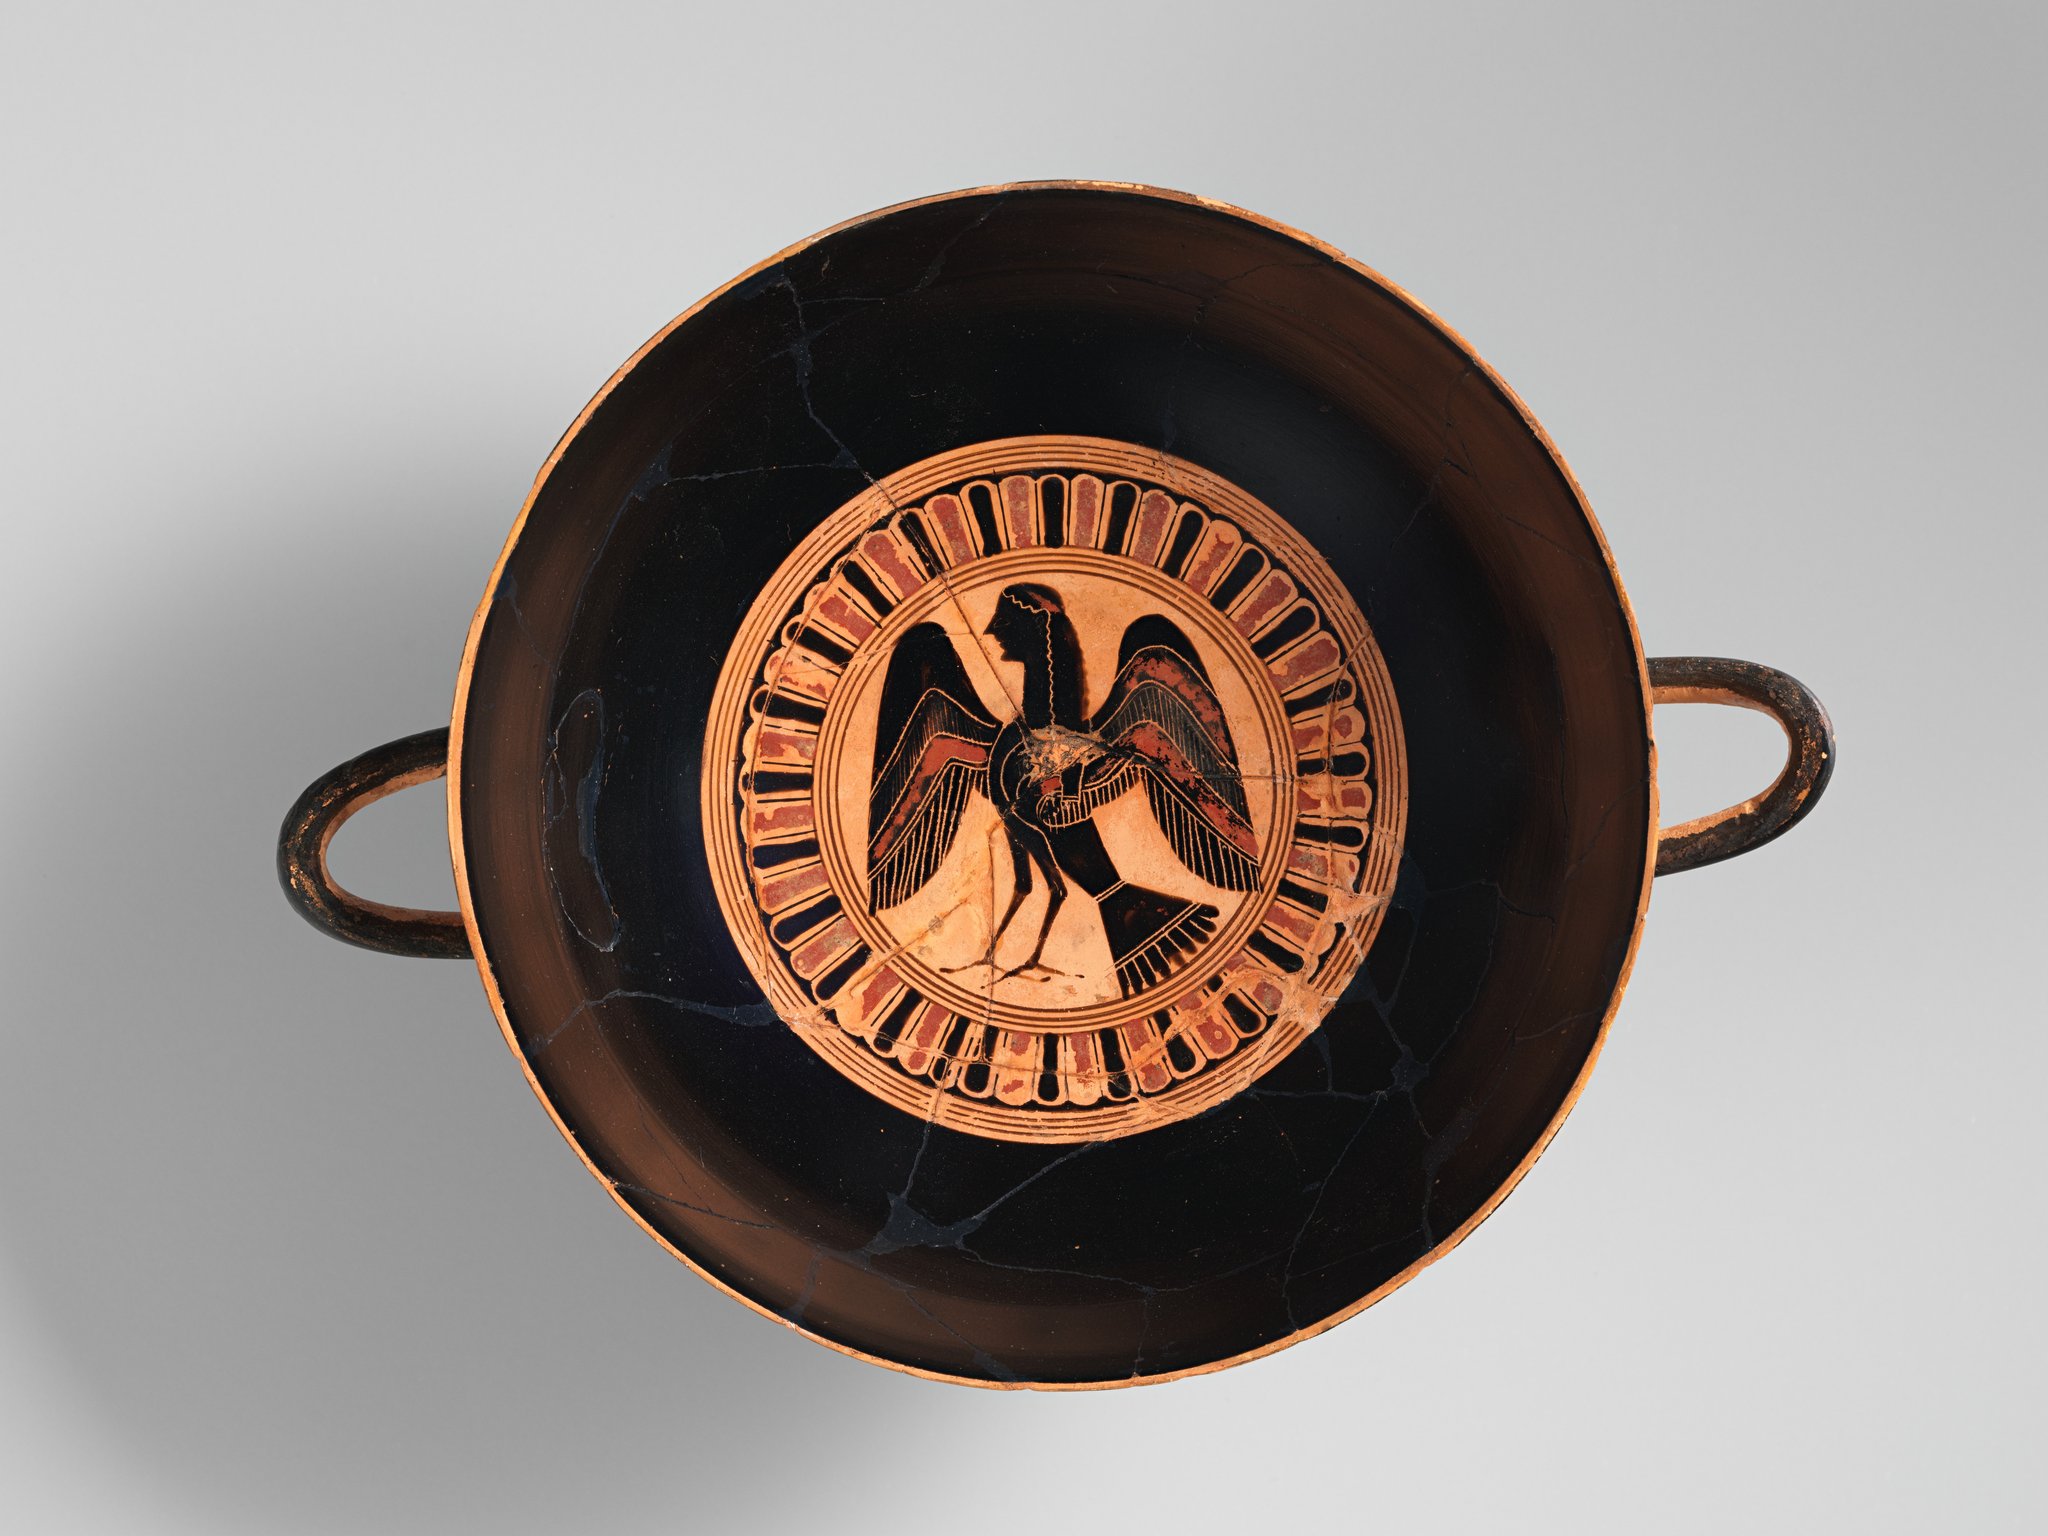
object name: kylix, lip cup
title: Terracotta kylix: lip-cup (drinking cup)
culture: greek, attic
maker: nearchos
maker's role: artist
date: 560-550 BCE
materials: terracotta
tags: sirens